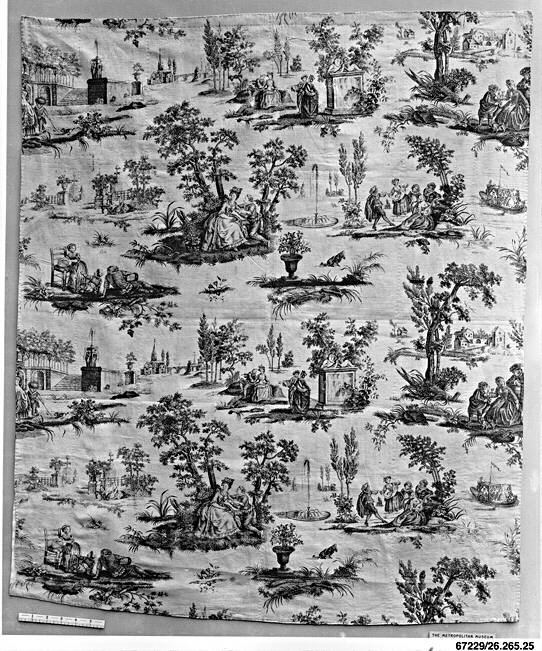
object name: furnishing textile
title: "The Tuileries Gardens"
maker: oberkampf manufactory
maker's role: manufactory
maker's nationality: french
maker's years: 1760-1843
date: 1785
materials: linen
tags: men,women,trees